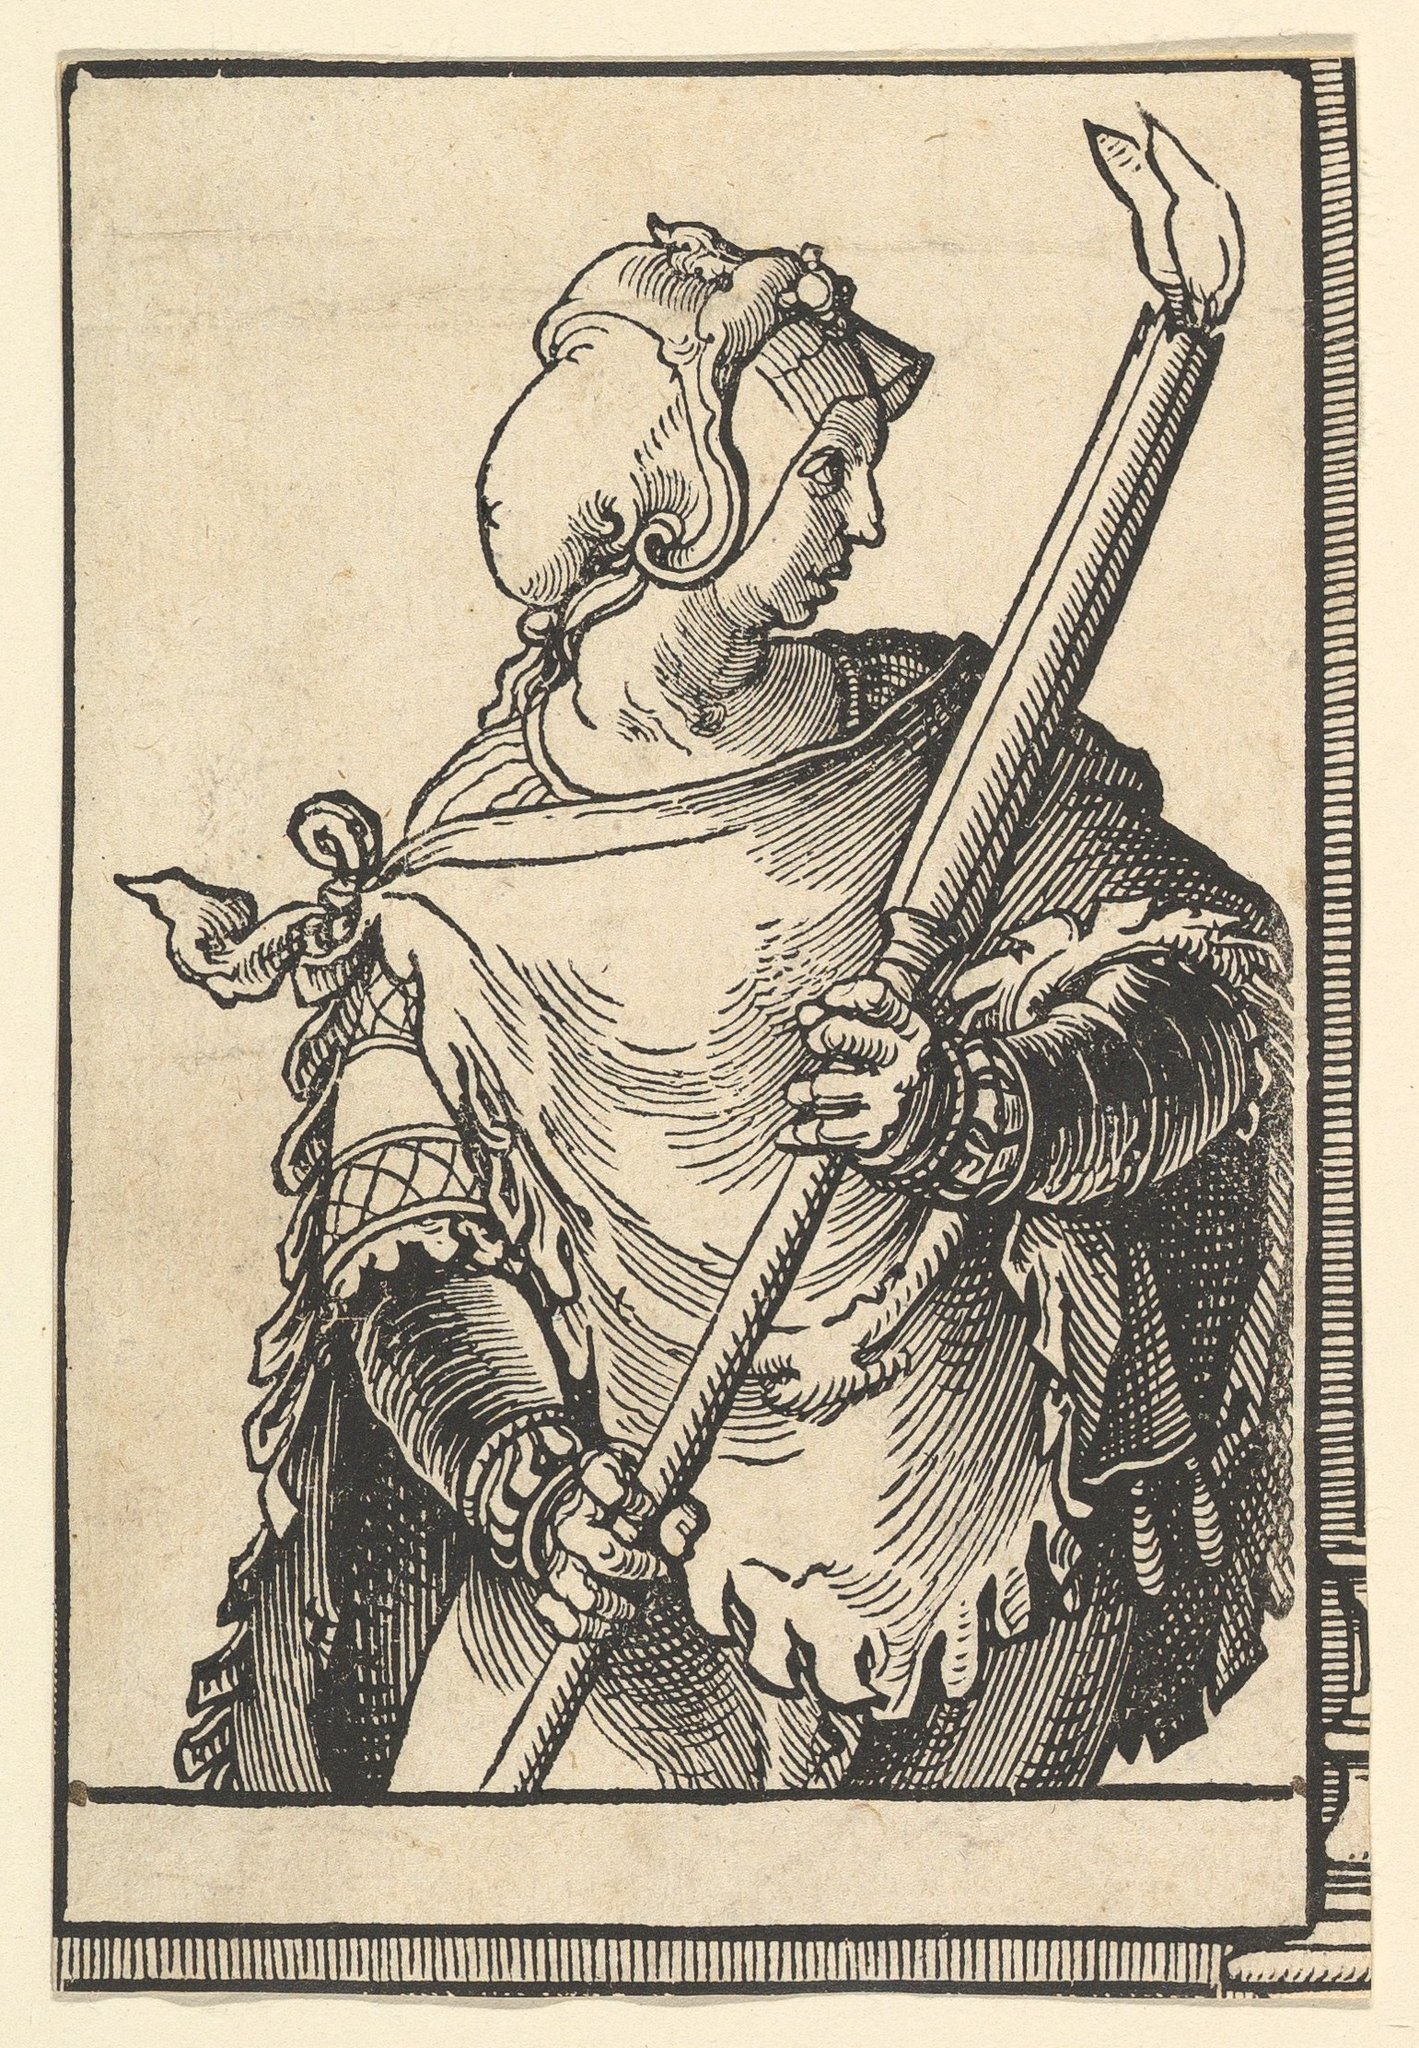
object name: print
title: Libyan Sibyl, from the series of Sibyls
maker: lucas van leyden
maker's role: artist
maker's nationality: netherlandish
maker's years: 1494-1533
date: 1530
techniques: woodcut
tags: sibyl